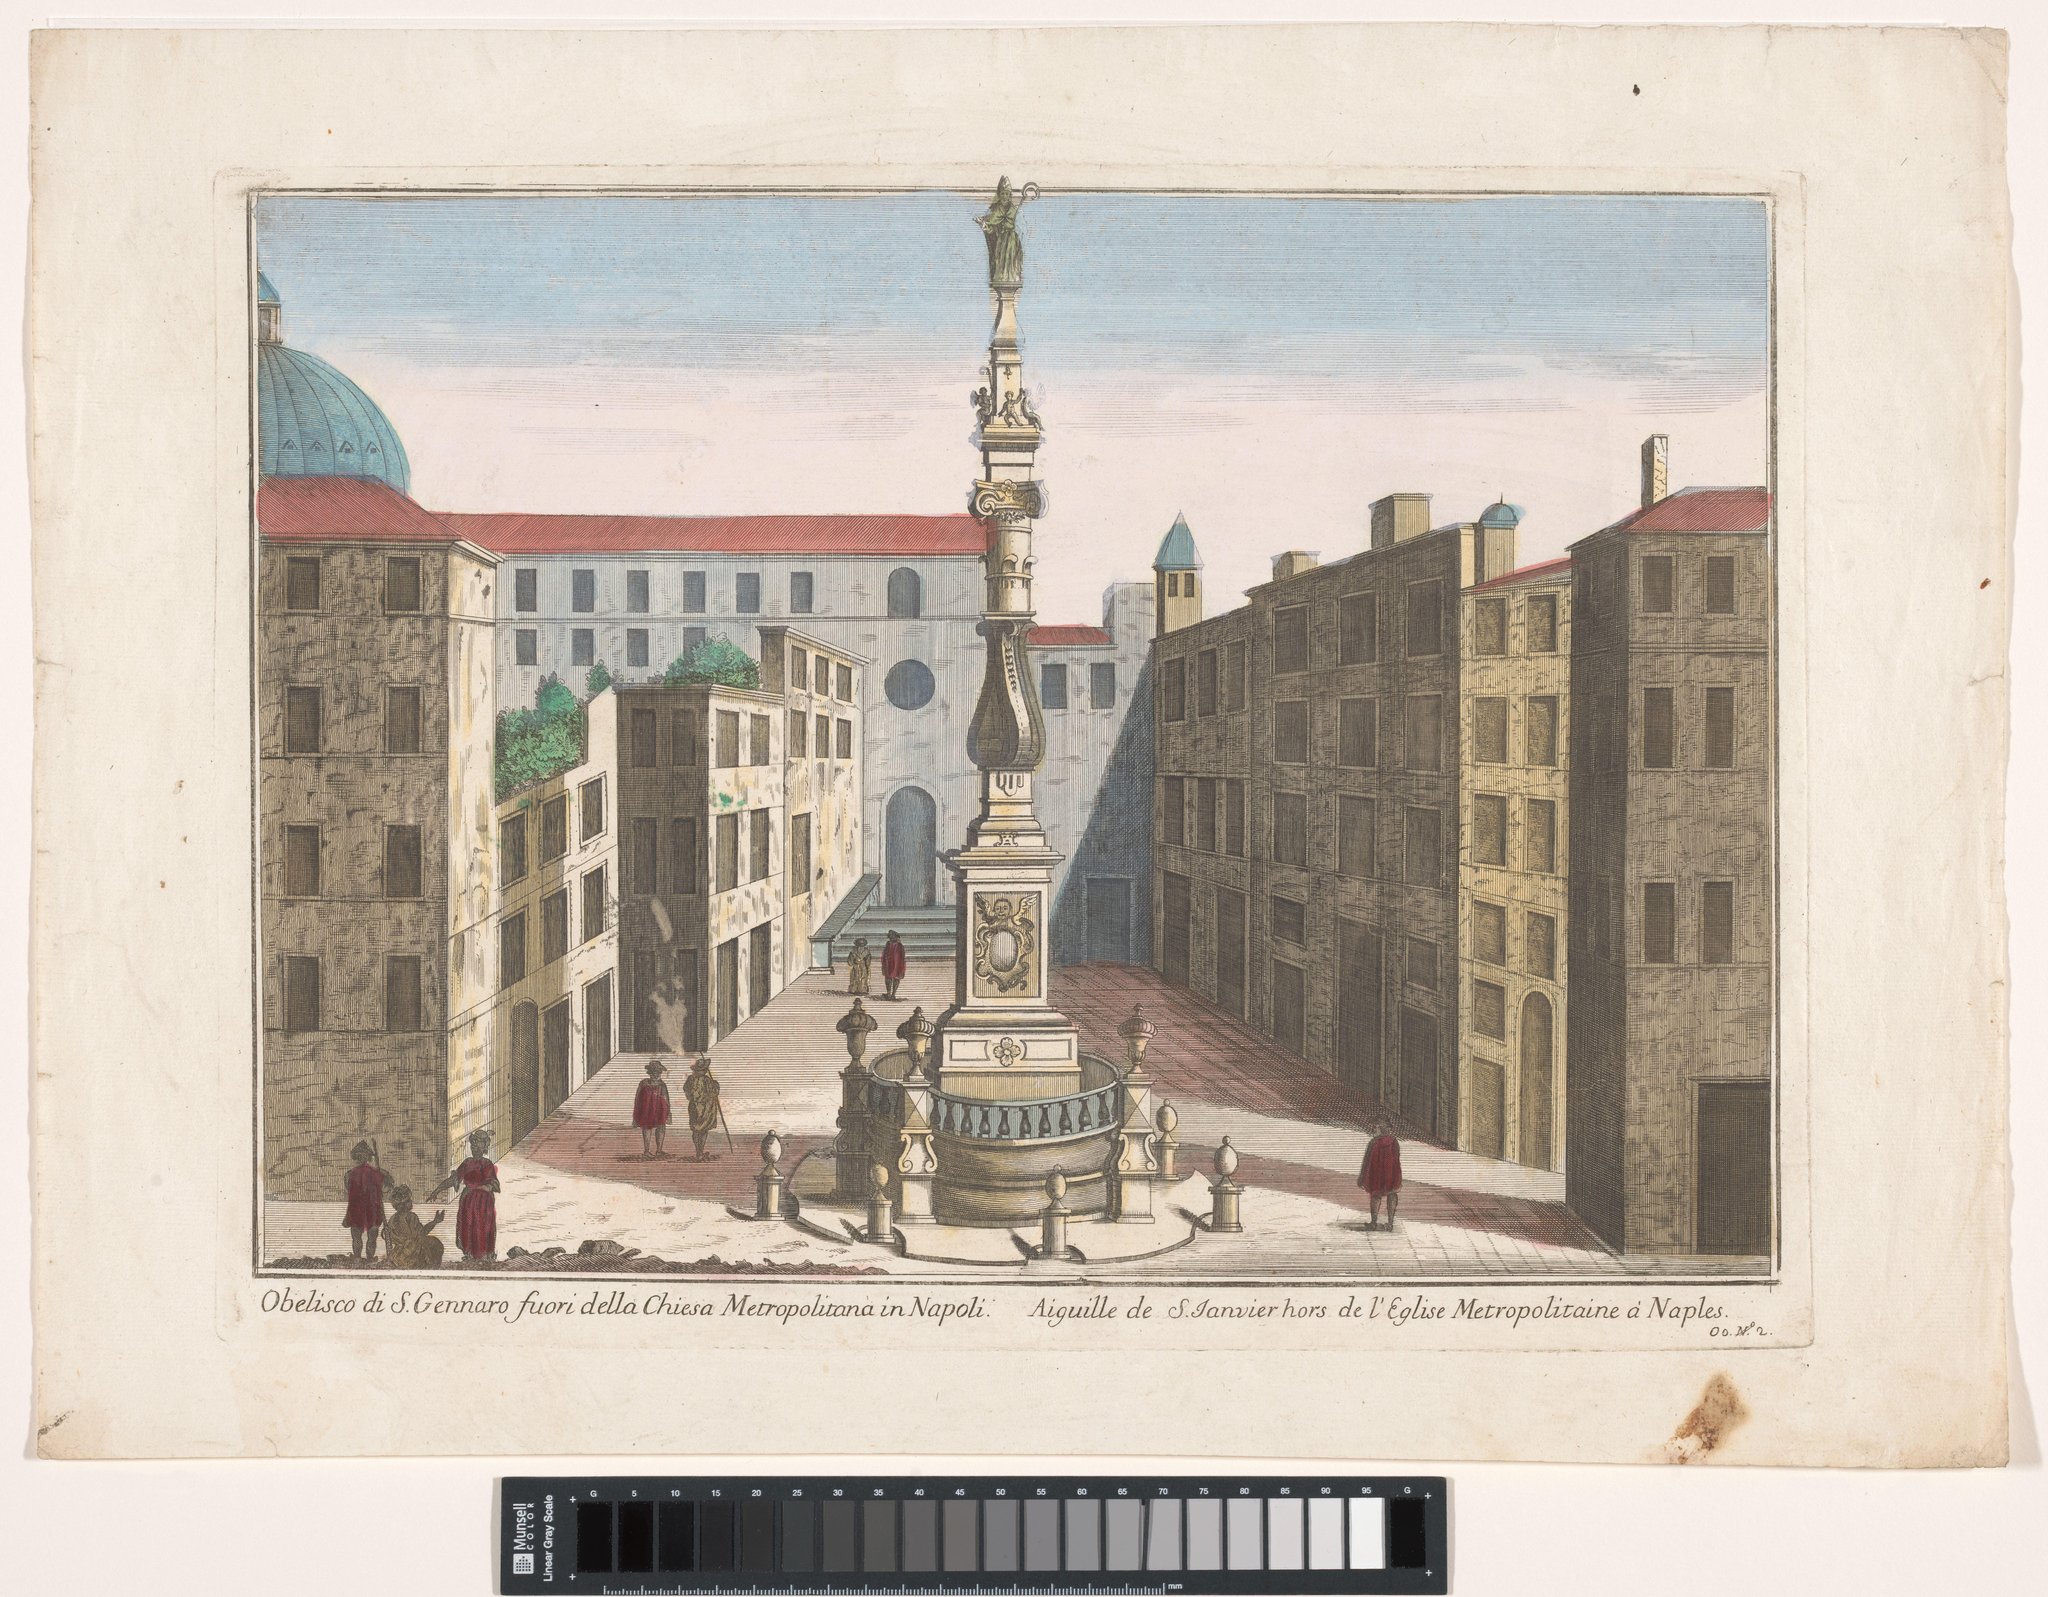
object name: print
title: Obelisco di S. Gennaro fuori della chiesa metropolitana in Napoli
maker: Anonymous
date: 1700-1799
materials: paper, watercolor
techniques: brush, etching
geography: bassano del grappa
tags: obelisk, needle (+ city(-scape) with figures, staffage), church (exterior), square, place, circus, etc. (+ city(-scape) with figures, staffage)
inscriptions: collector's mark: Lugt 2228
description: Op de achtergrond de Dom. Rechtsonder genummerd: Oo 2.